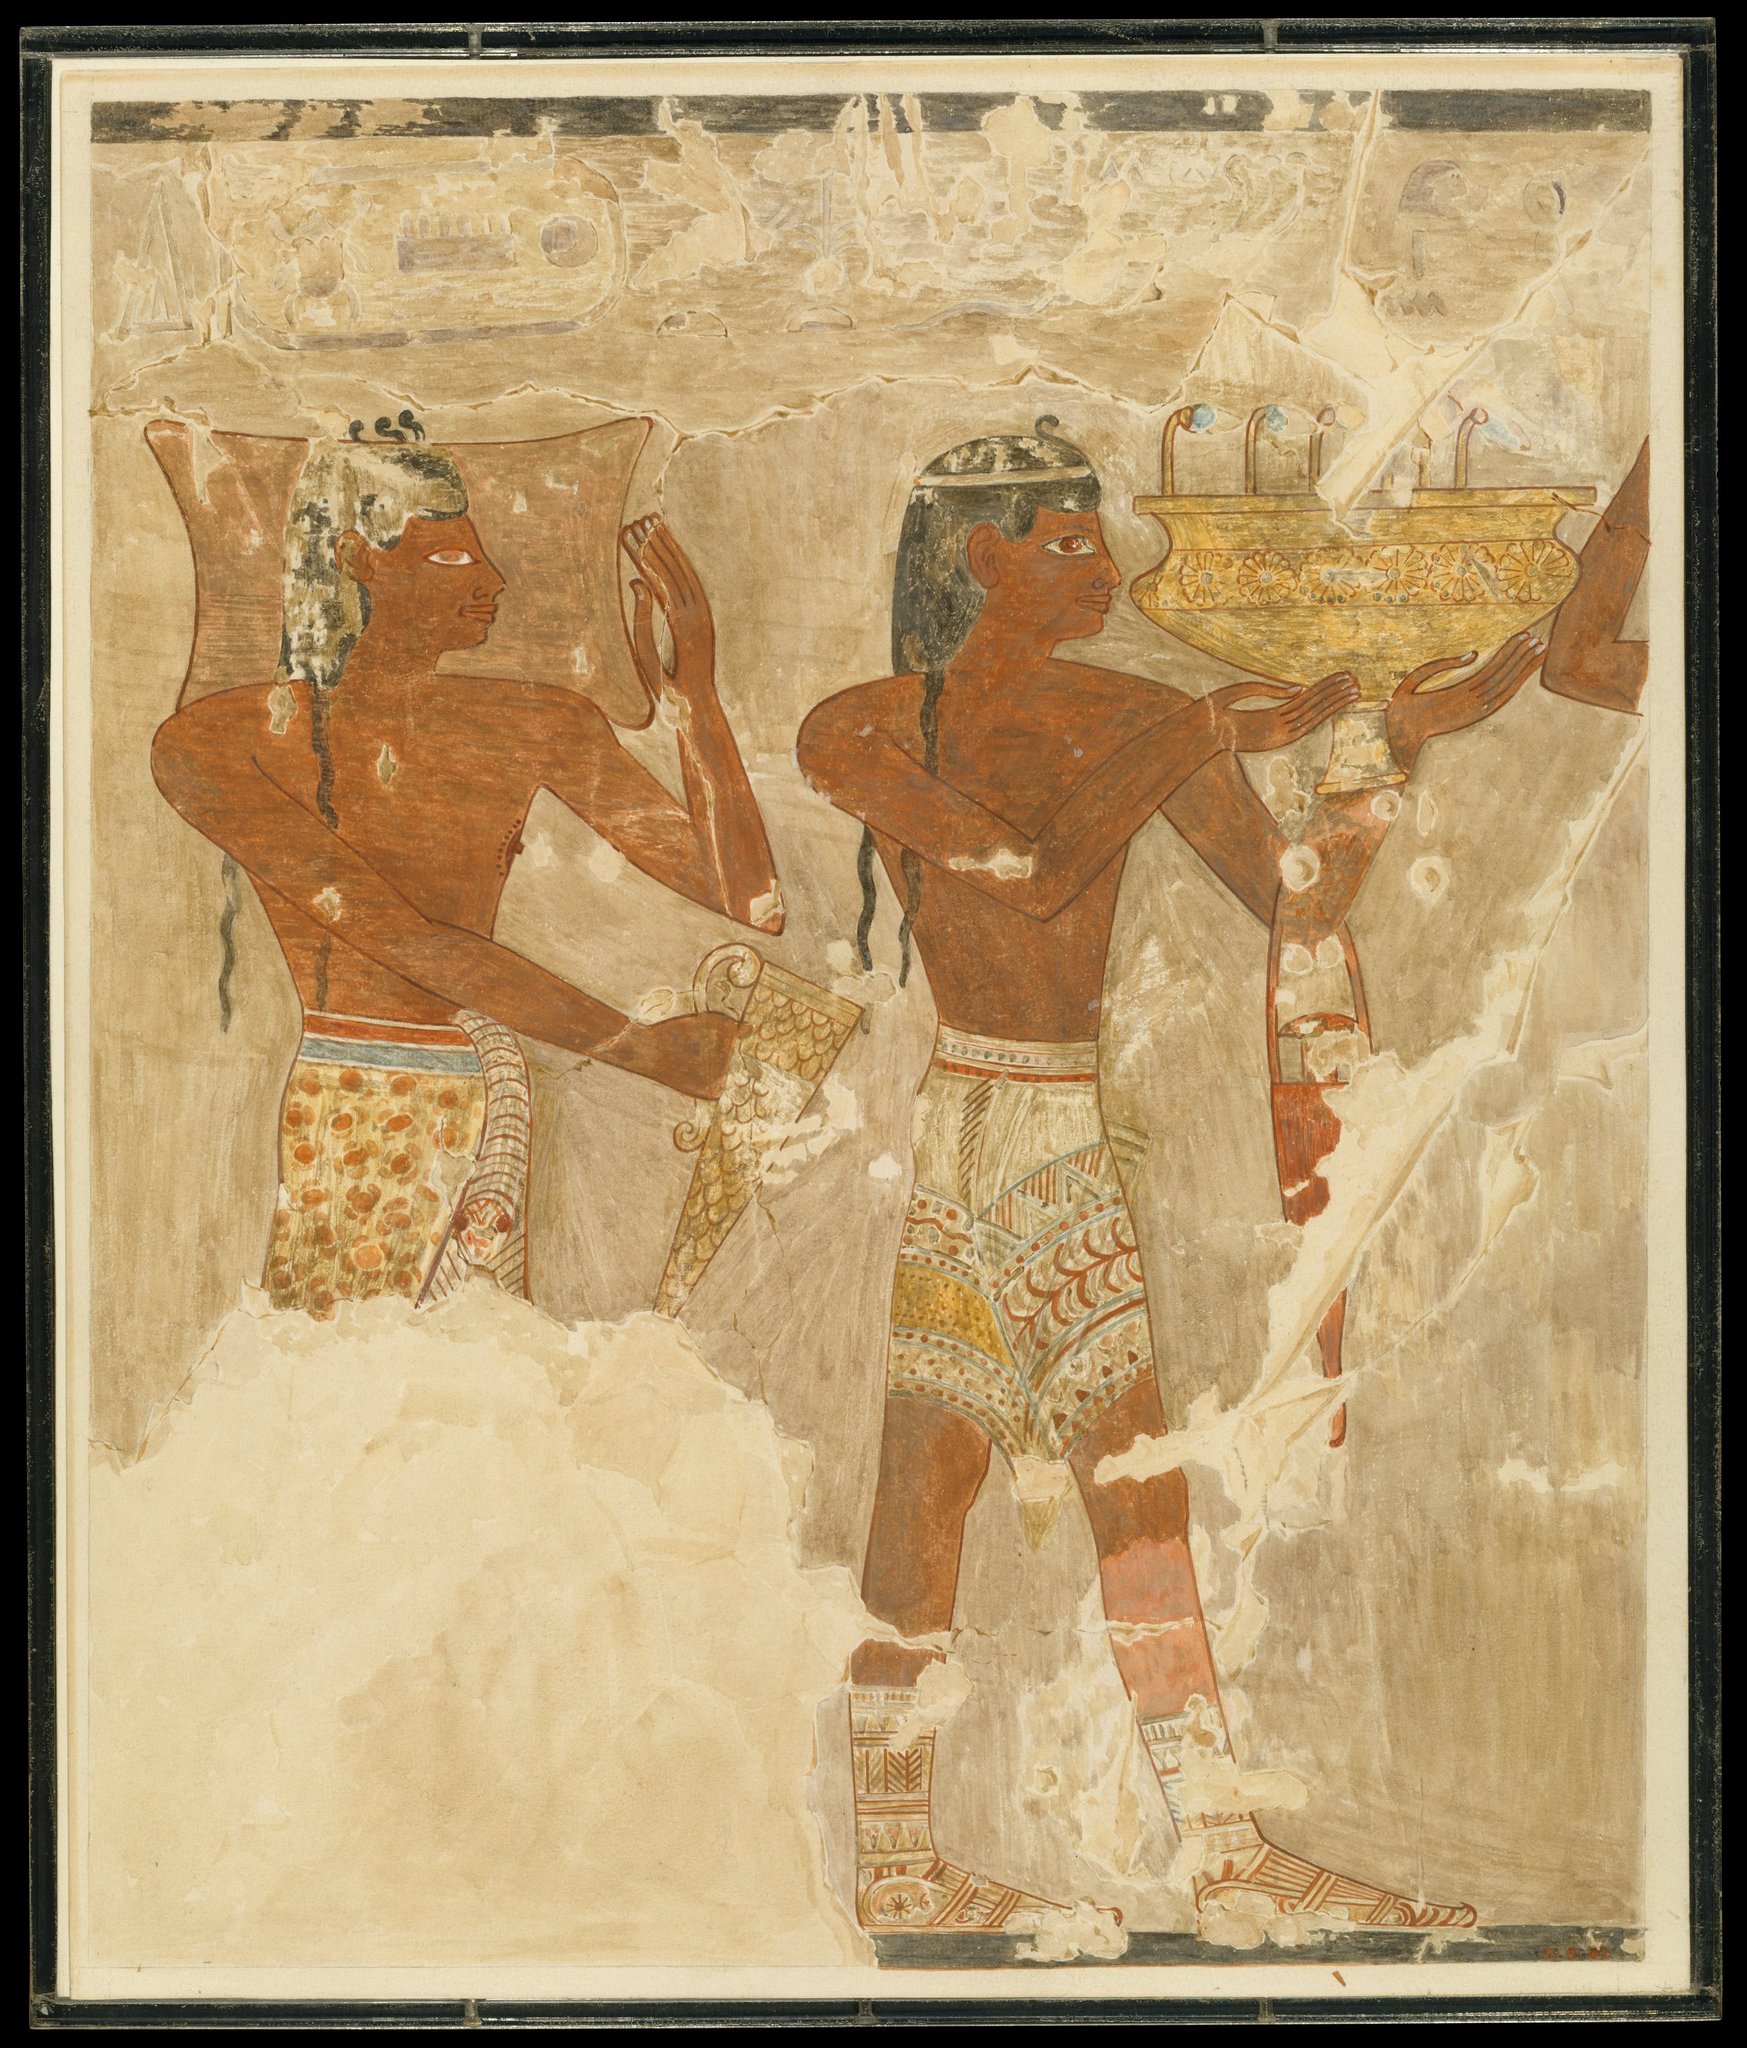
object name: facsimile, rekhmire tt 100, foreigner, keftiu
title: Cretans Bringing Gifts, Tomb of Rekhmire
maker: nina de garis davies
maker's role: artist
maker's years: 1881-1965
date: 1479-1425 BCE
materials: ink, paint, paper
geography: egypt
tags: men,walk-like-egyptian